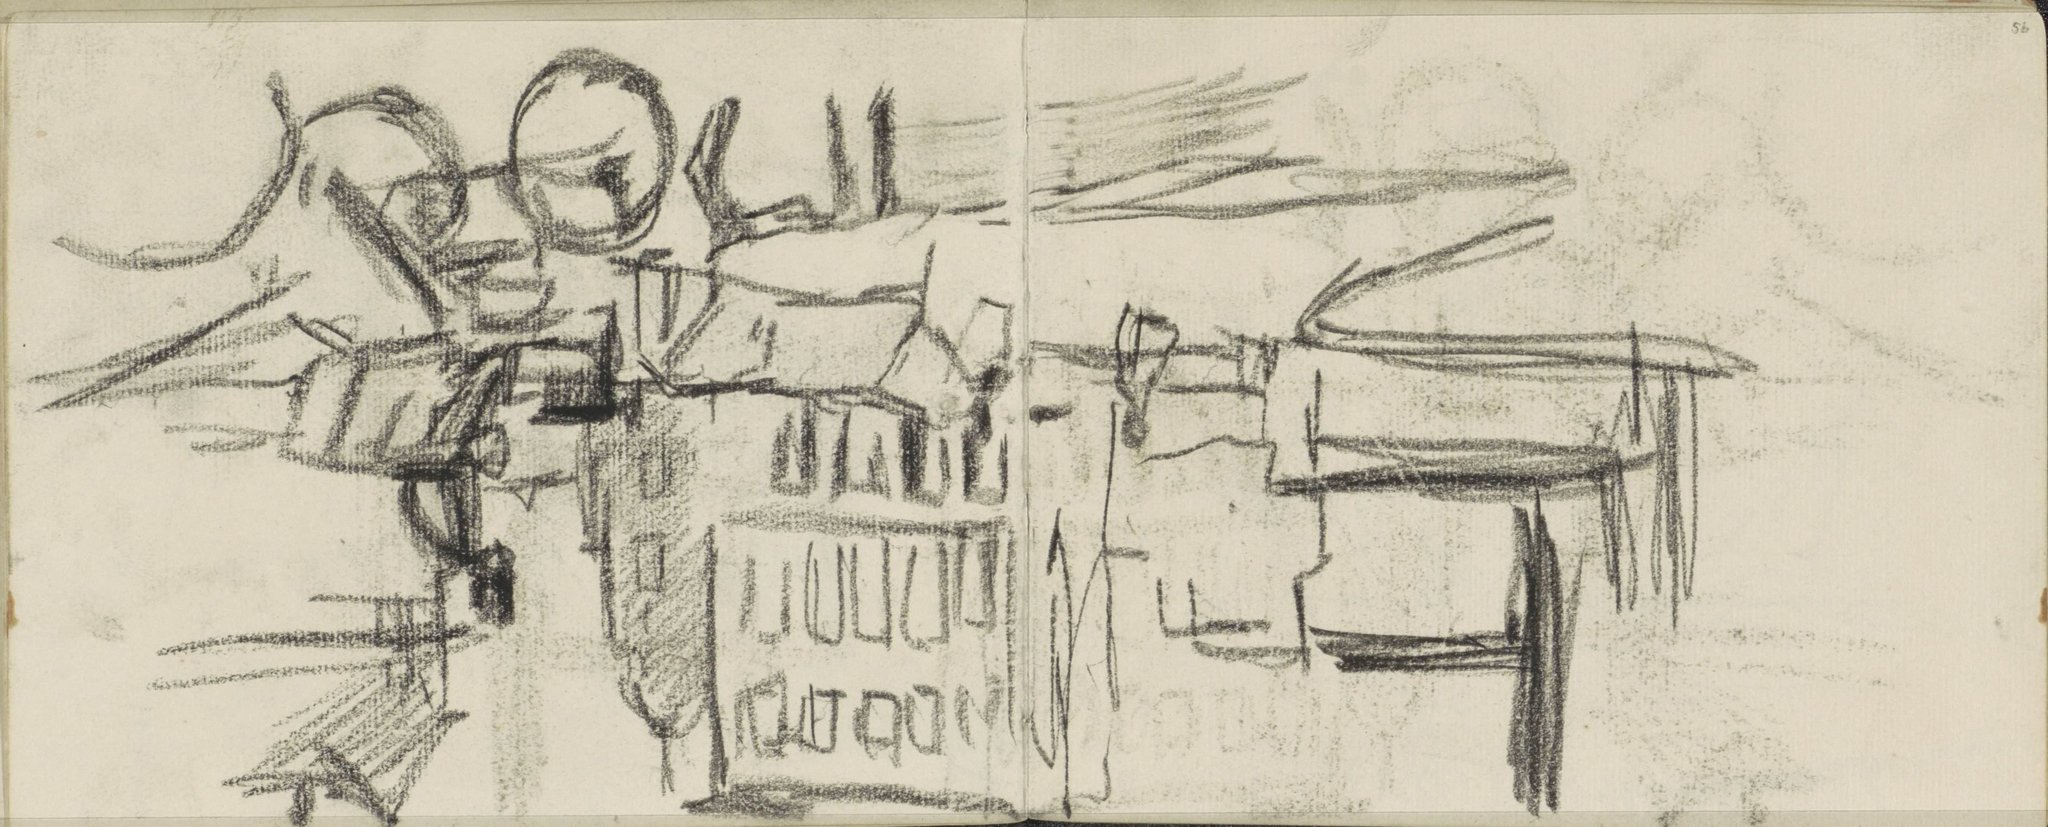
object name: sketchbook leaf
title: Gezicht op de Dam te Amsterdam met rijtuigen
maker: george hendrik breitner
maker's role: draughtsman, painter, print maker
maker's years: 1857-1923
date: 1886-1903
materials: chalk, paper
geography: amsterdam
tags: four-wheeled, animal-drawn vehicle, e.g.: cab, carriage, coach, palace, church (exterior), square, place, circus, etc. (+ city(-scape) with figures, staffage), royal palace of amsterdam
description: Gezien vanaf de Beurs van Zocher. Op de achtergrond het Koninklijk Paleis en de Nieuwe Kerk. Pagina 55 en pagina 56 uit een schetsboek met 32 bladen.